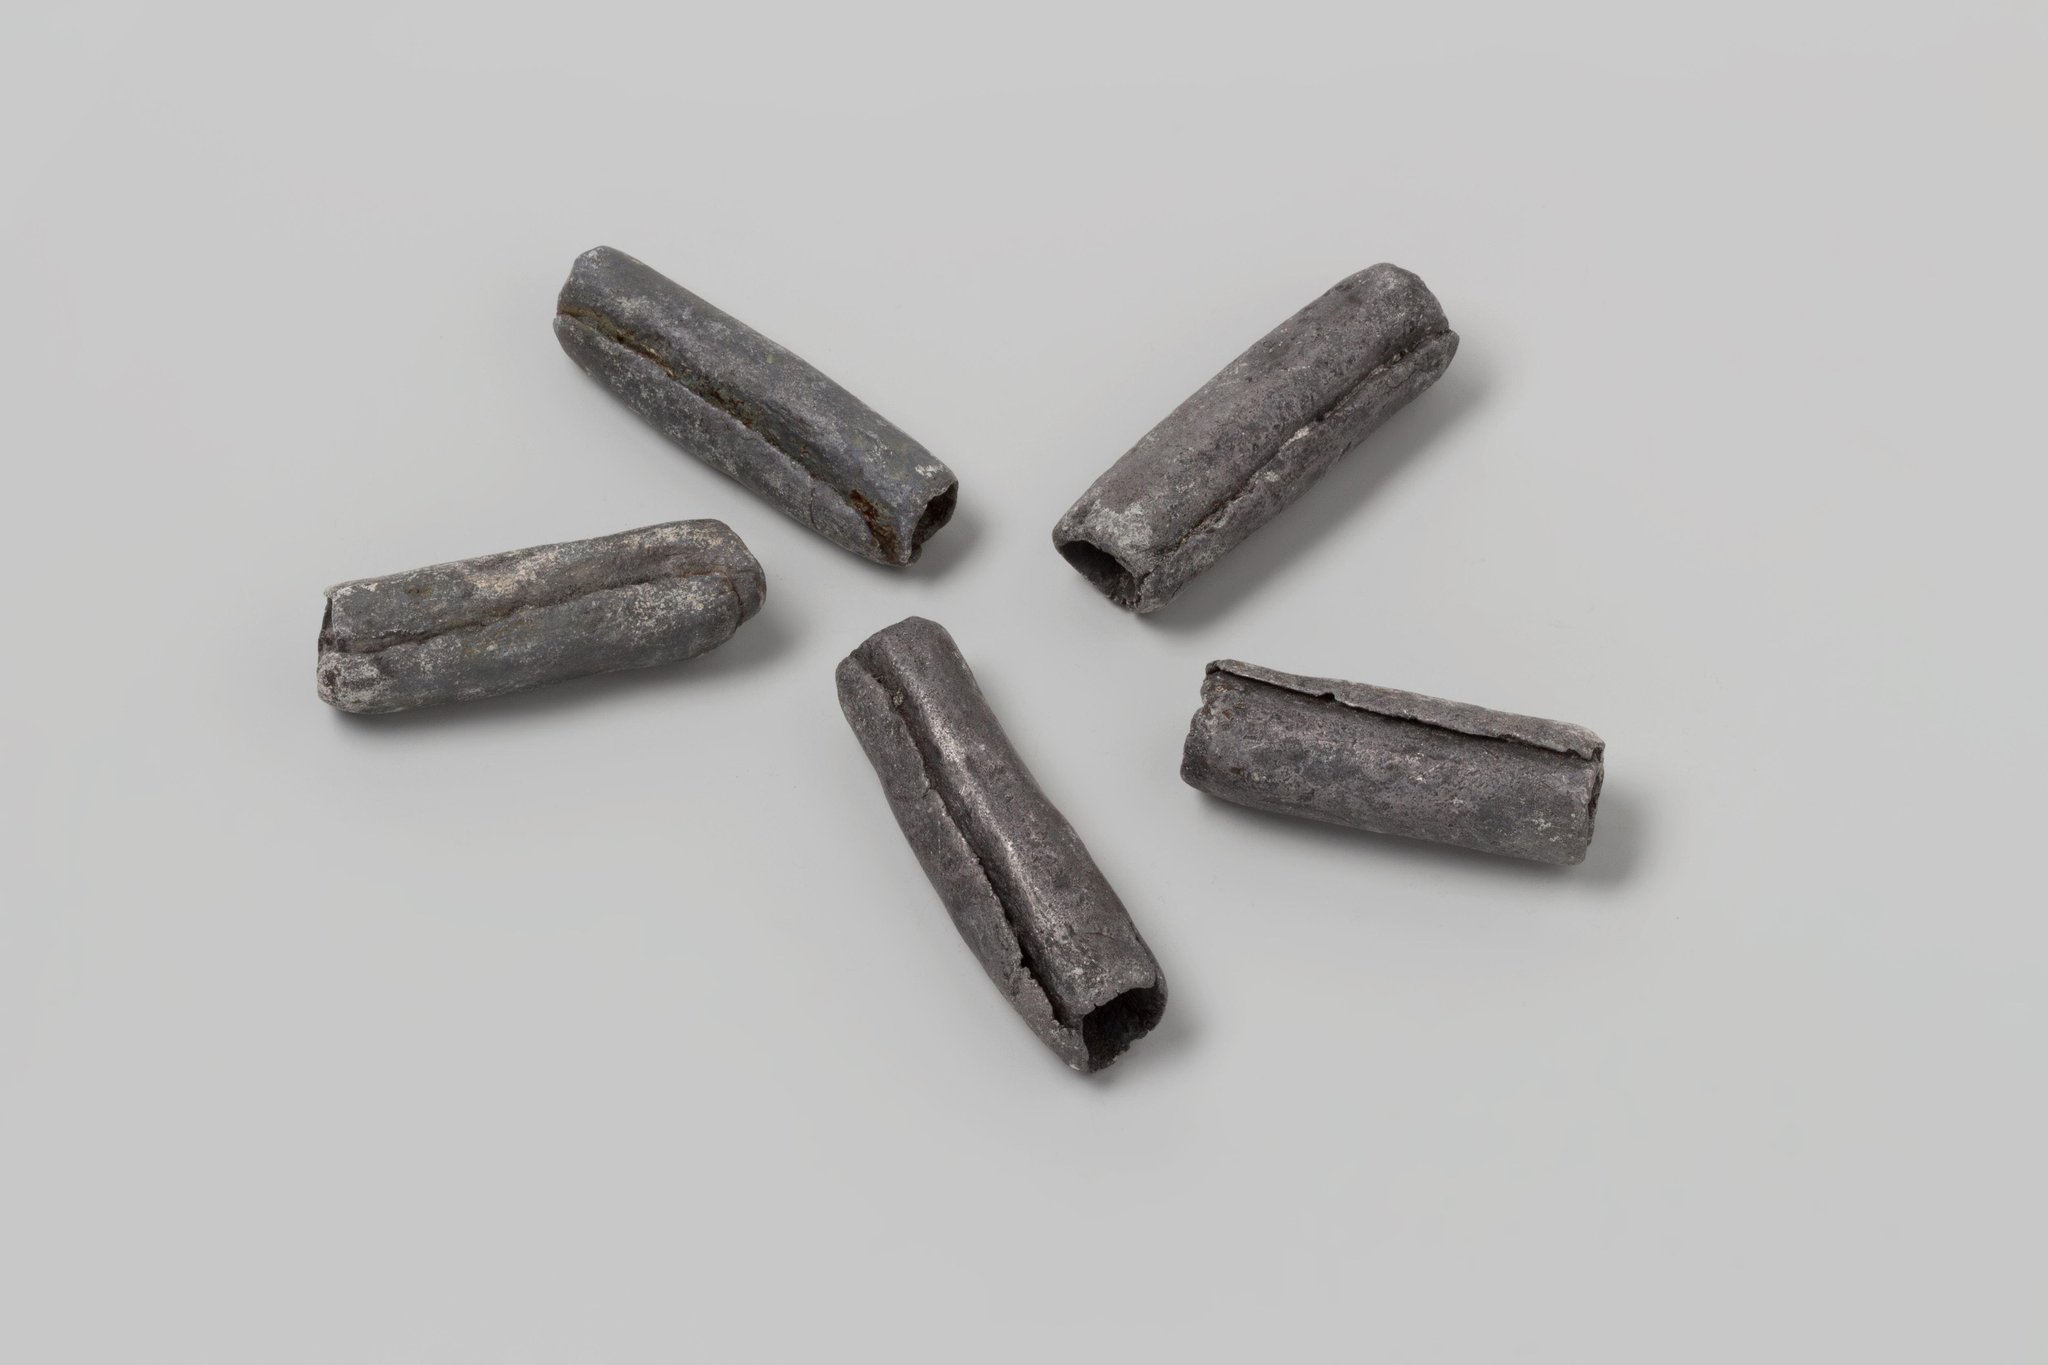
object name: lead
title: Loden rol uit het wrak van de Oost-Indiëvaarder 't Vliegend Hart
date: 1700-1735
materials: lead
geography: middelburg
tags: 't vliegend hart (schip), verenigde oostindische compagnie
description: Deze loden buisjes zijn vermoedelijk afkomstig van visnetten ofwel op TVliegend Hart zelf ofwel van vissers die hun netten aan het wrak verloren.